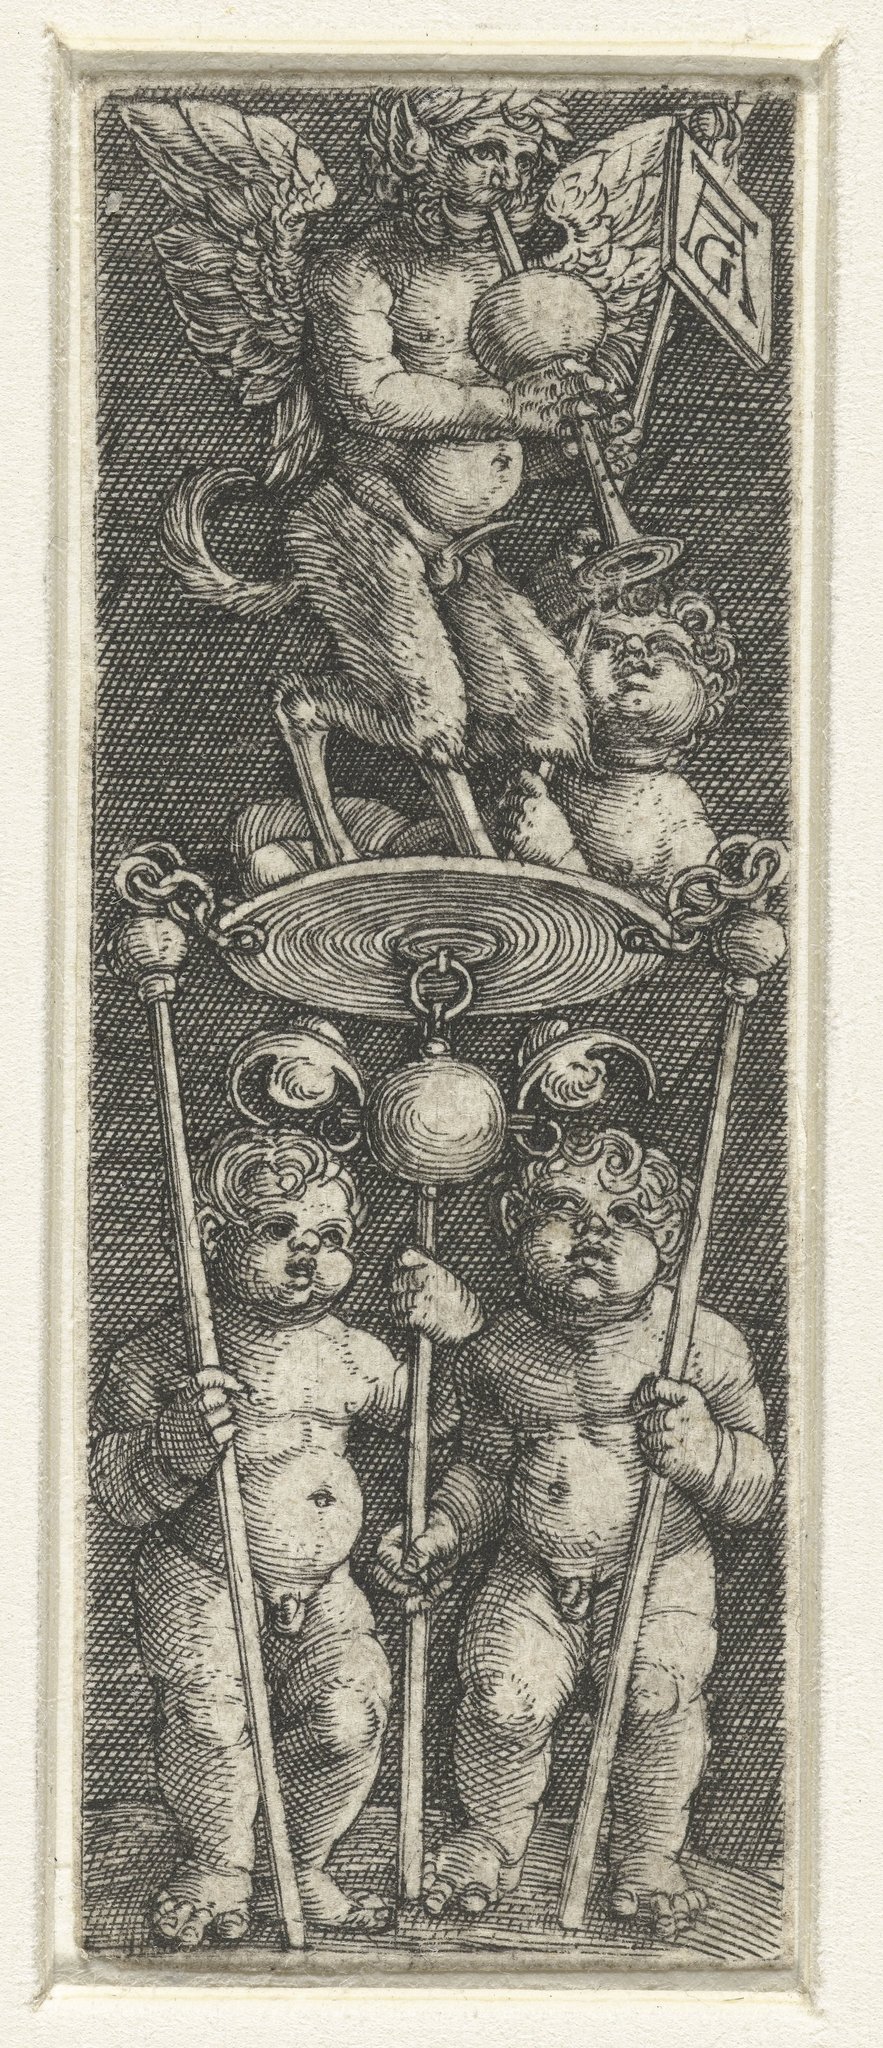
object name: ornament print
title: Drie kinderen en een gevleugelde sater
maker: heinrich aldegrever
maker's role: draughtsman, print maker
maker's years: 1502-1561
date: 1525-1529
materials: paper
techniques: engraving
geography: germany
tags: ornaments ~ art, one person playing wind instrument, child, satyr(s) (in general)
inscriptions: number: ‘22’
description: Vlakdecoratie met twee jongetjes die met stokken een schild omhoog houden. Op het schild staat een gevleugelde sater die een blaasinstrument bespeelt, en een derde jongetje met een stok in zijn handen.